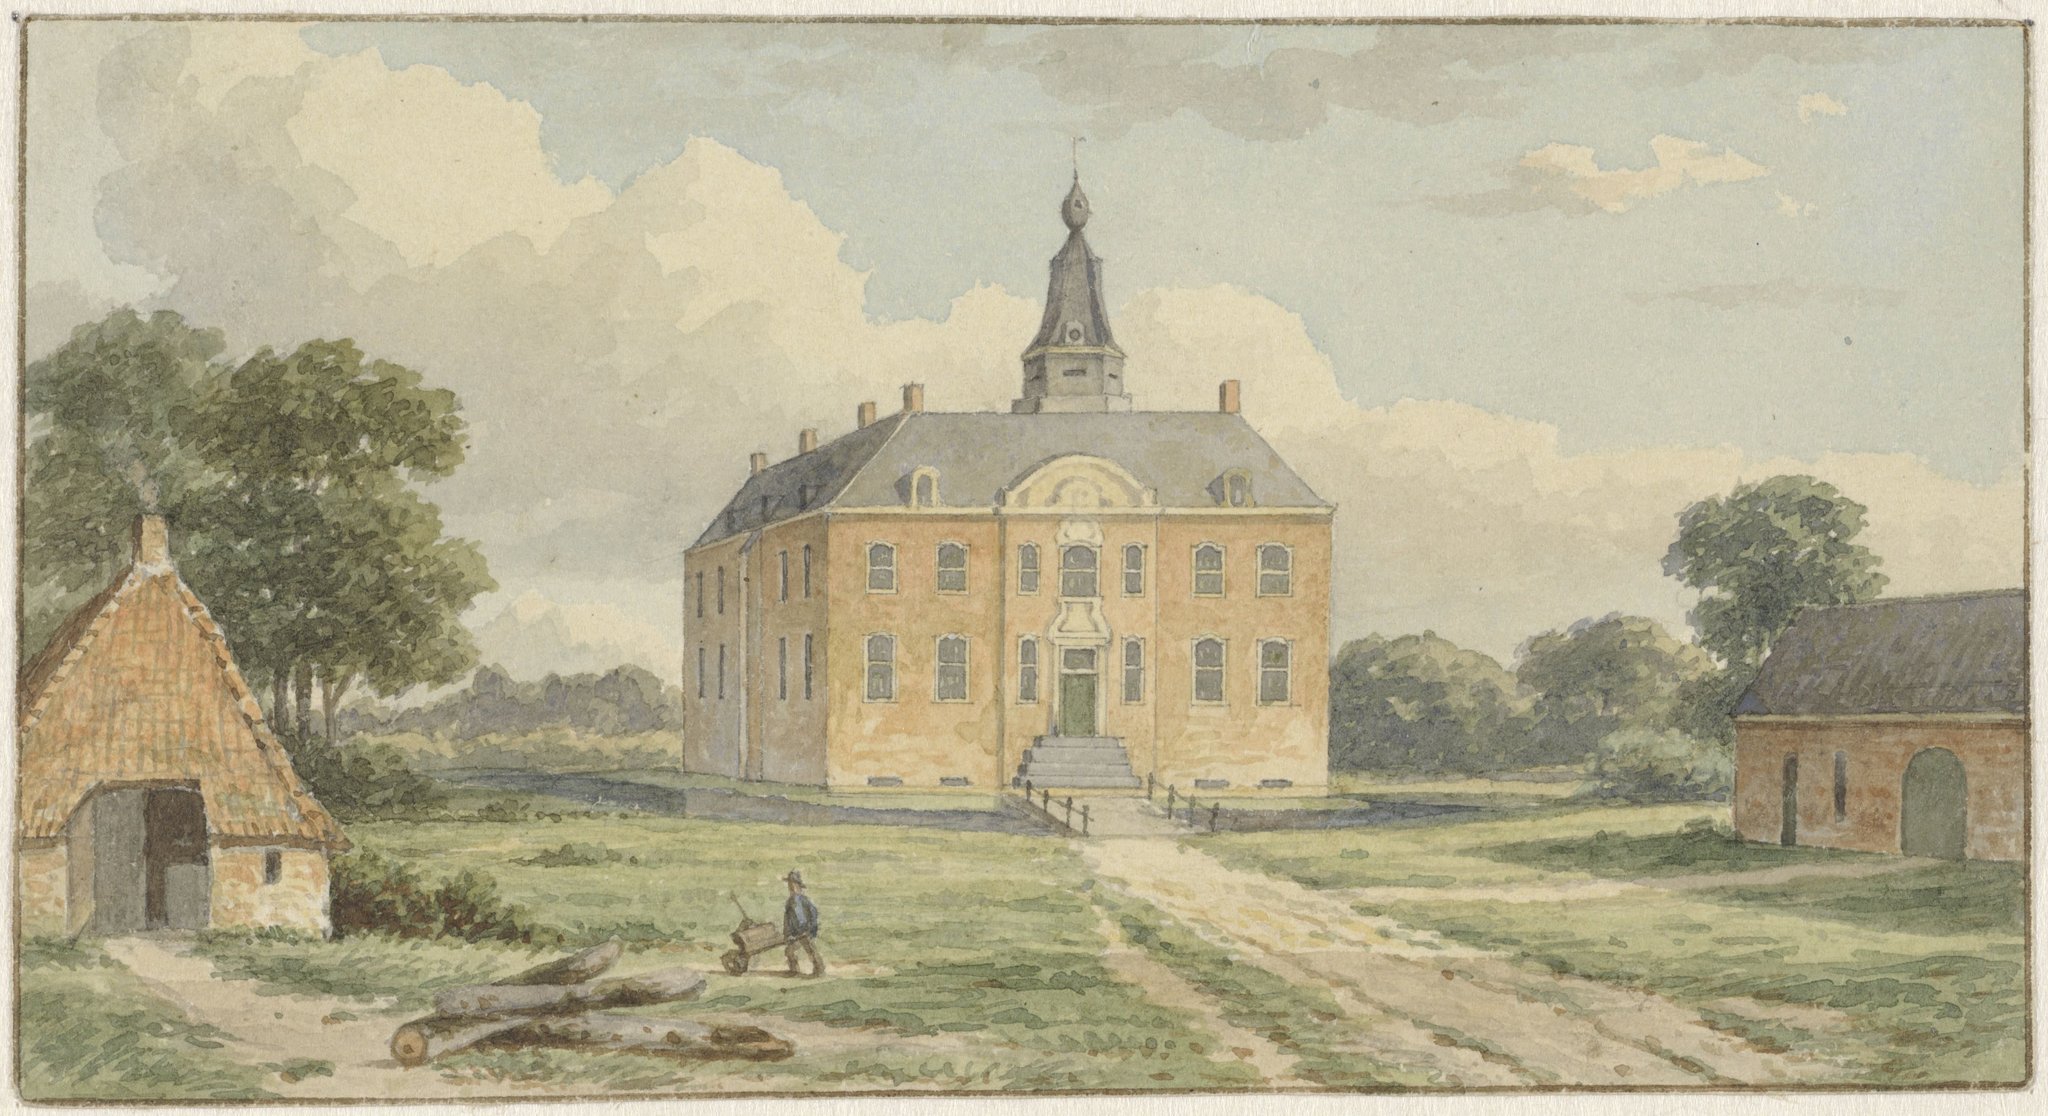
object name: watercolor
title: Het Huis Nettelhorst, bij Lochem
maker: christianus hendricus hein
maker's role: draughtsman, print maker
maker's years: 1815-1879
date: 1825-1879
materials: paper, watercolor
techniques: brush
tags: castle